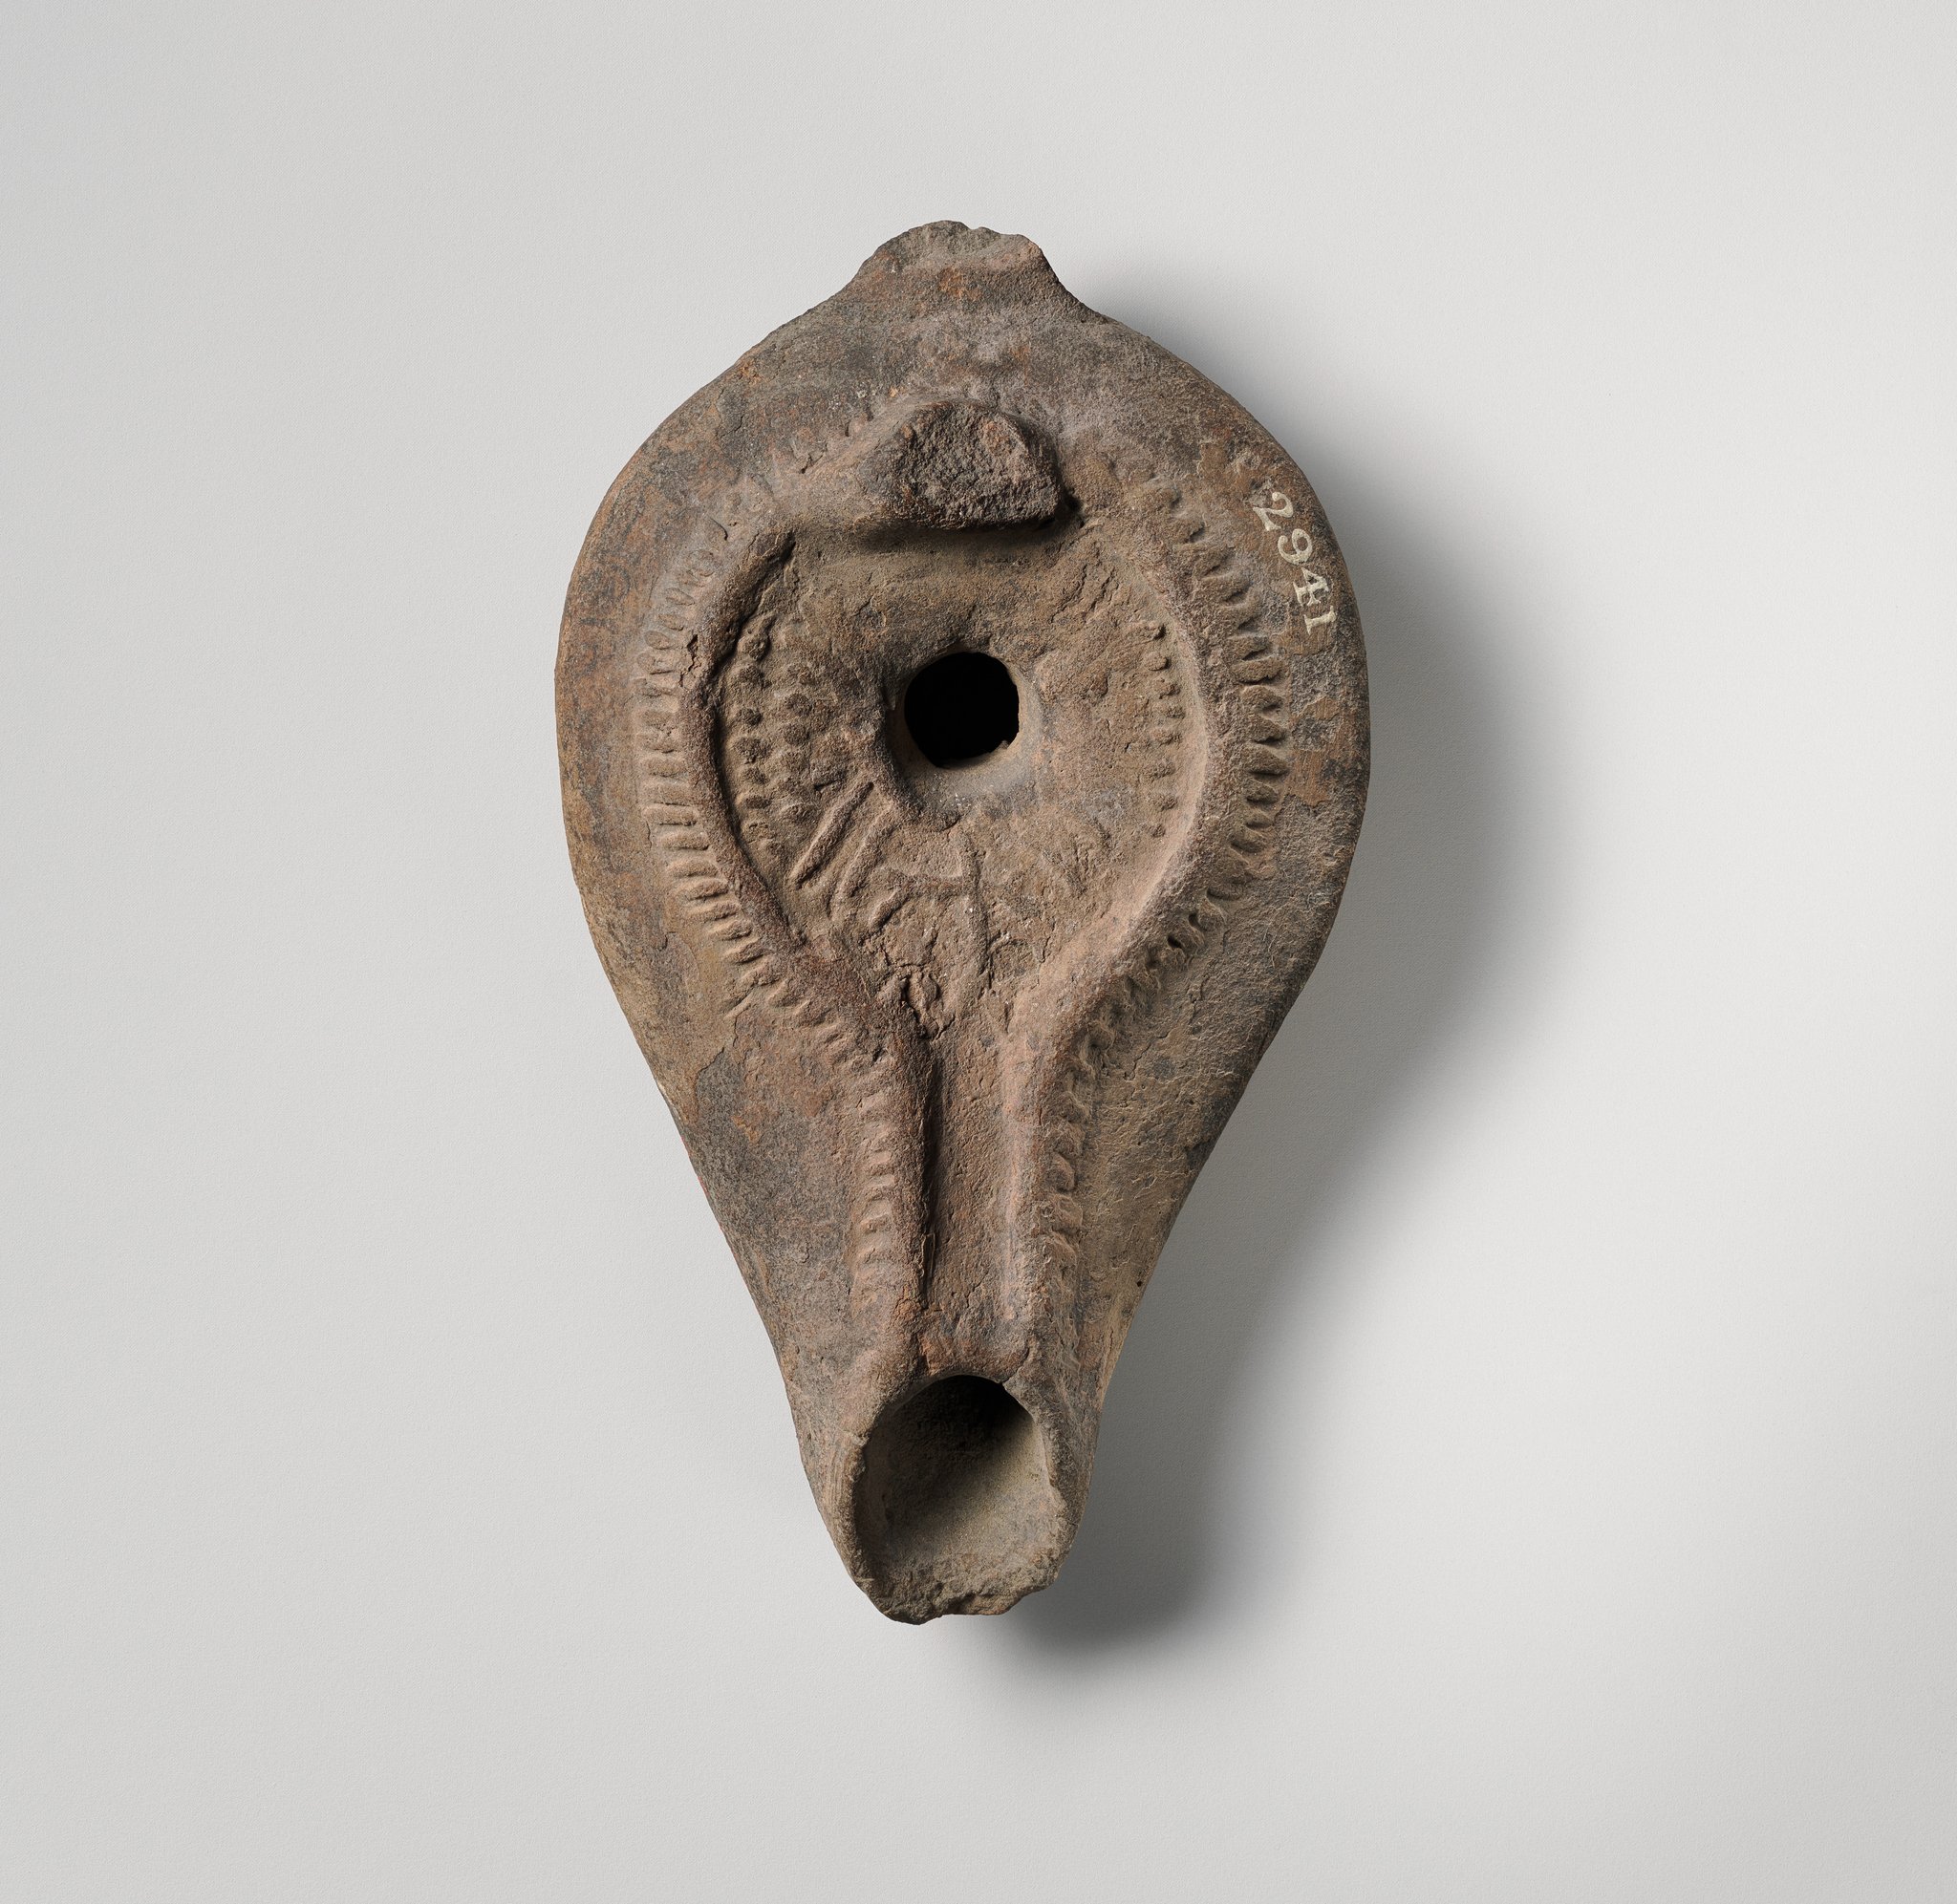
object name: lamp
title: Terracotta oil lamp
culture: roman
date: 670 BCE-330 CE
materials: terracotta